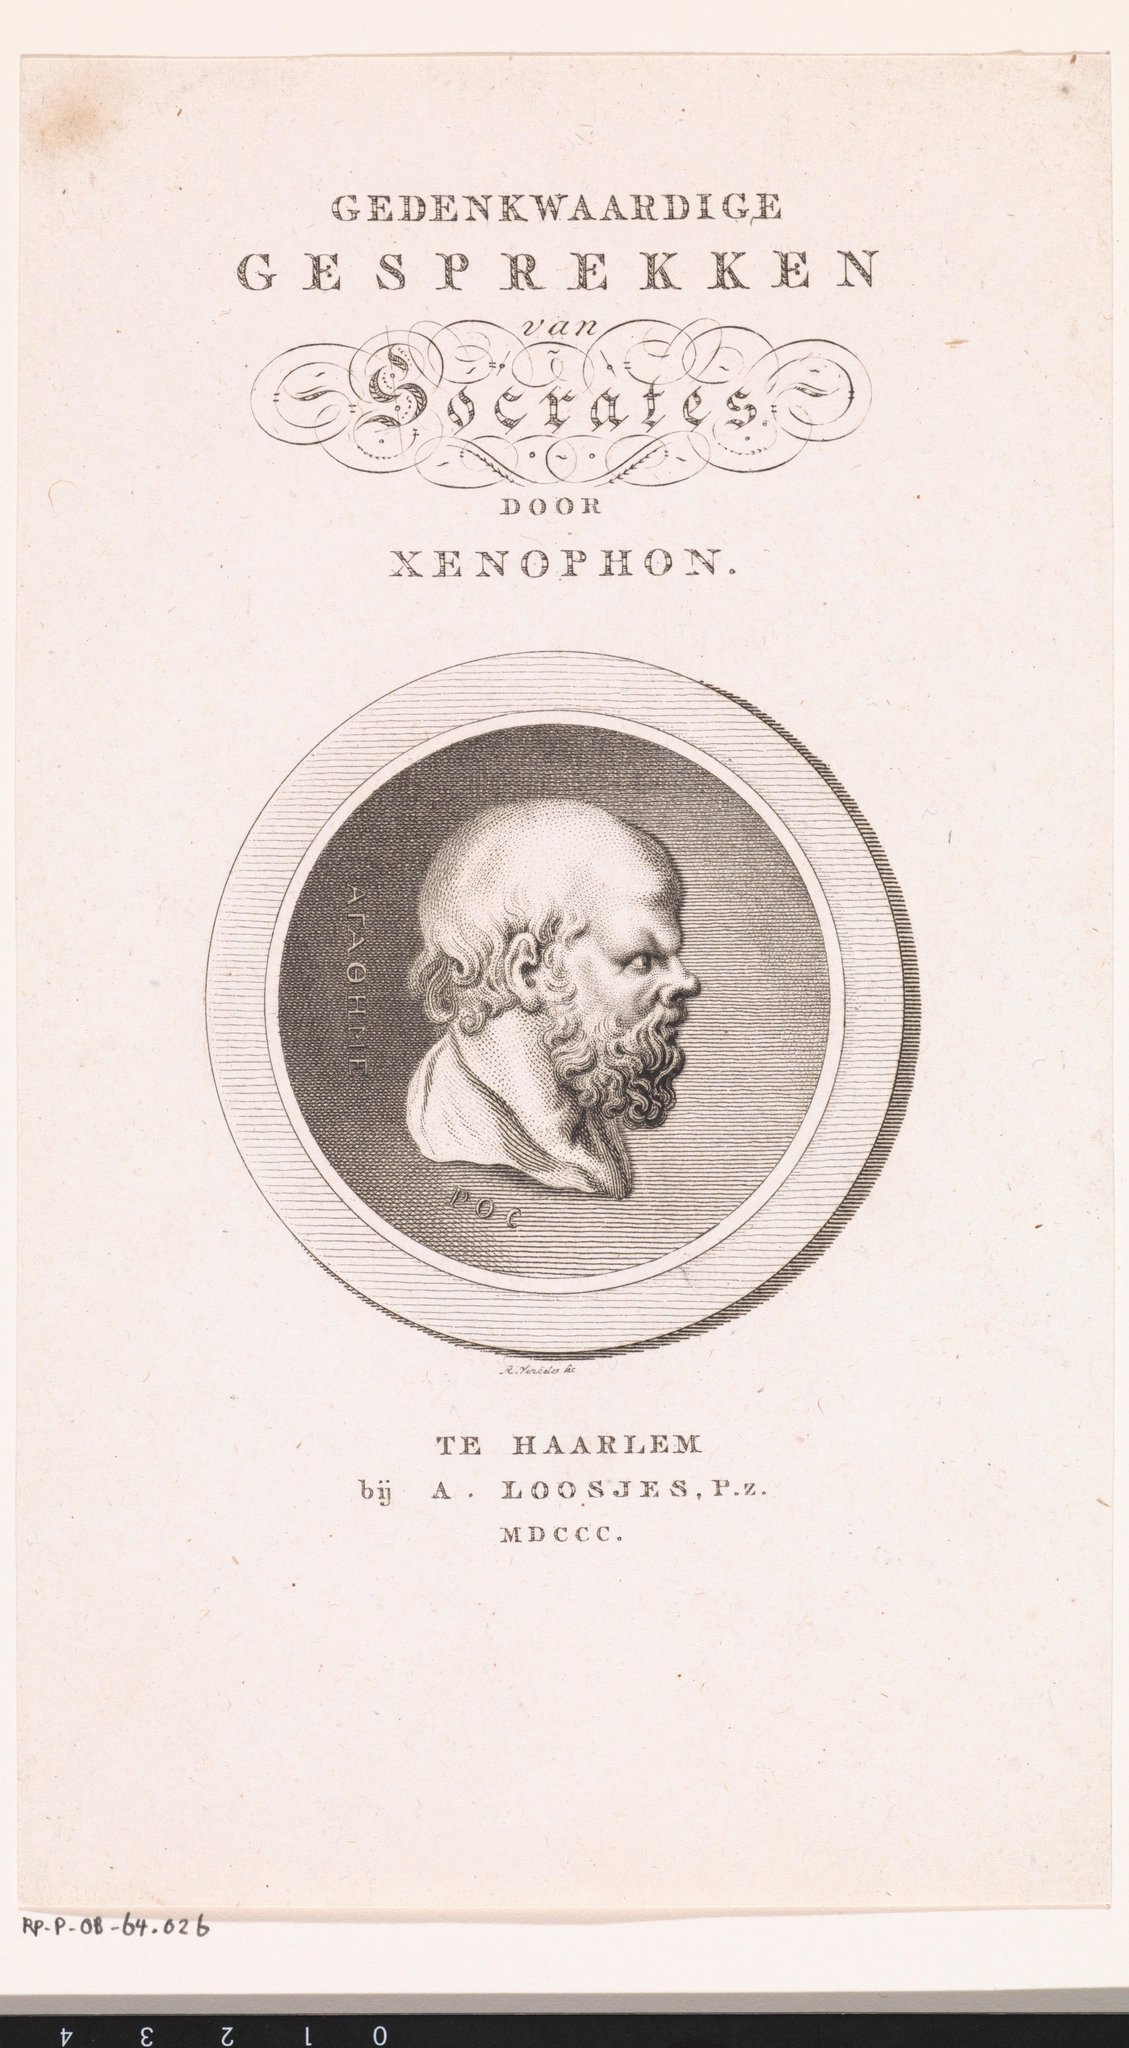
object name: print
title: Titeagina voor: Xenophon, Gedenkwaardige Gesprekken van Socrates, 1800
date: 1800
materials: paper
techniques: engraving, etching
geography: haarlem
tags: socrates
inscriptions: collector's mark: Lugt 2228